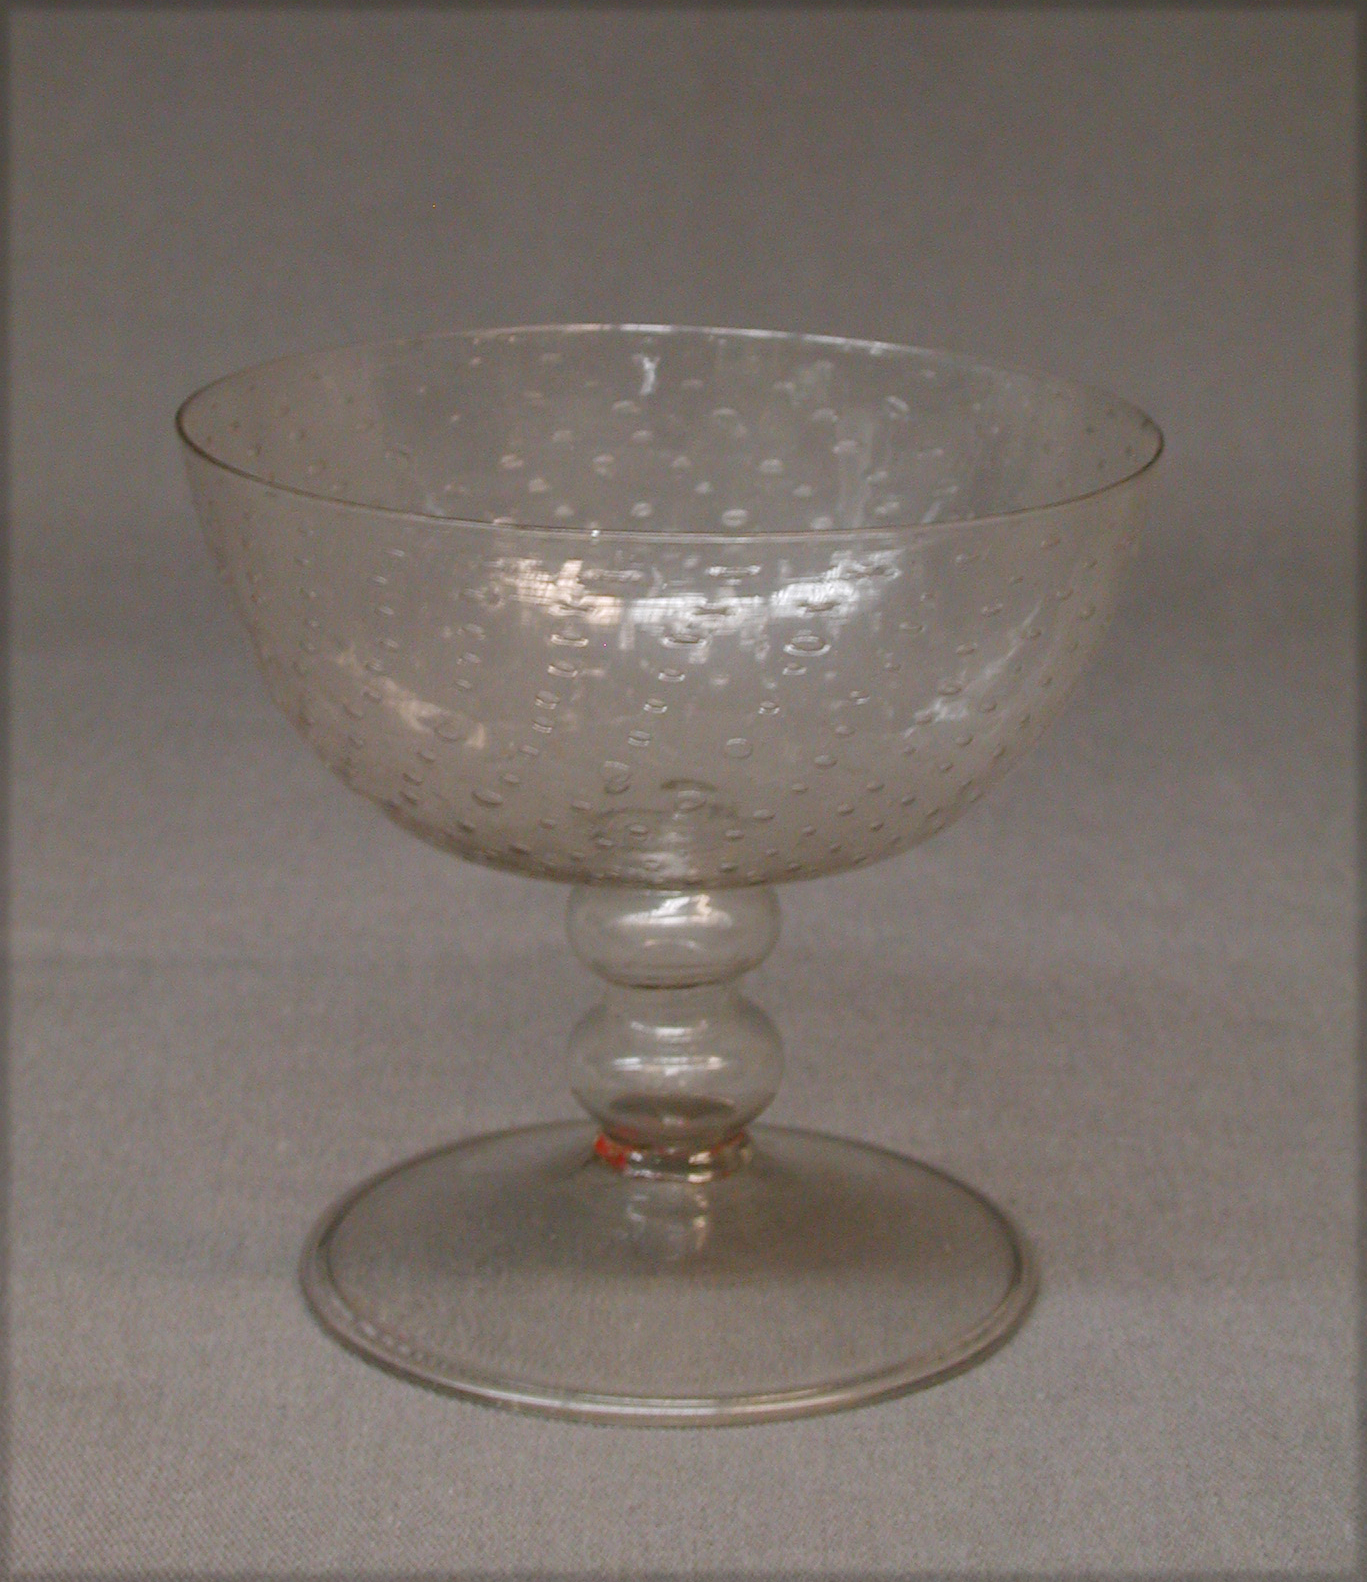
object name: wineglass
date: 1601-1700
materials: glass